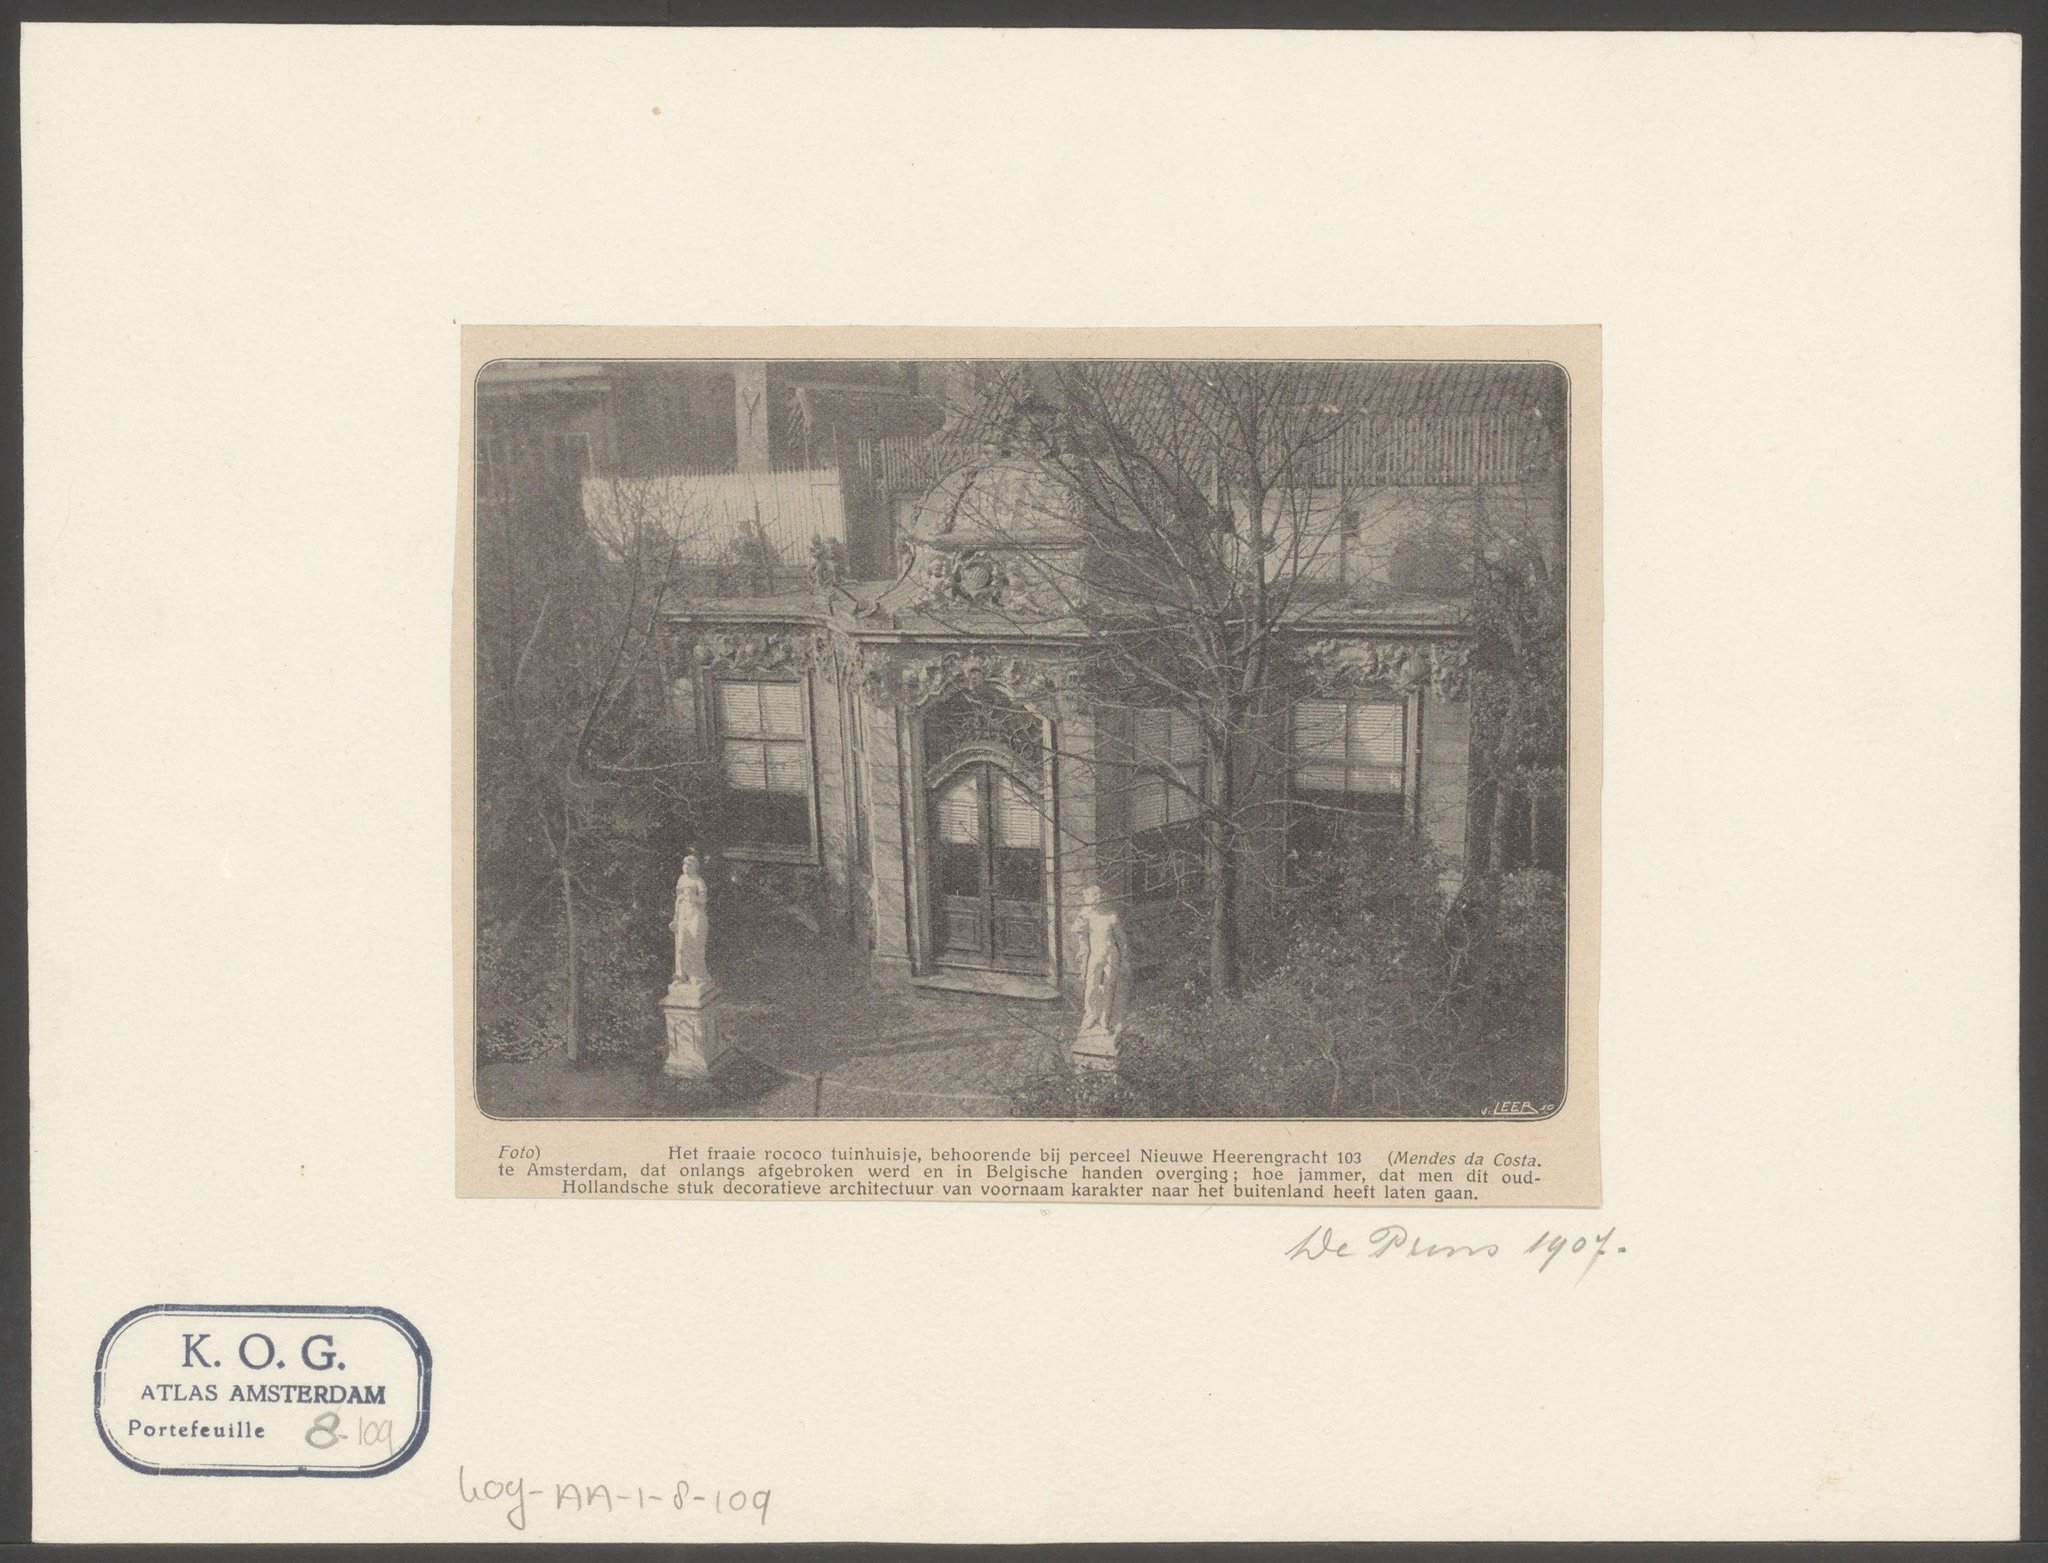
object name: photomechanical print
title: Gezicht op een tuinhuisje toebehorend aan een pand aan de Nieuwe Herengracht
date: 1907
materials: paper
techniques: letterpress printing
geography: amsterdam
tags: city-view in general; 'veduta', summer-house, arbour, garden-house (dutch: 'theekoepel')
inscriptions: collector's mark: ‘8.109’ Lugt 1641b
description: Onderwerpsrubriek binnen de Atlas Amsterdam: Heerengracht (Nieuwe), Heiligeweg, Heisteeg, Heintjehoeksteeg, Hekelveld, Hemelrijk, Hoedemakerspad, Hol (‘t), Houtgracht, Houtewaelerboom, Houtkoopersdwarsstraat, Houttuinen (Joden), Houttuinen (Haarlemmer), Hugo de Grootkade, Huidenstraat, Huidenvetterstraat, Huydecoperstraat.